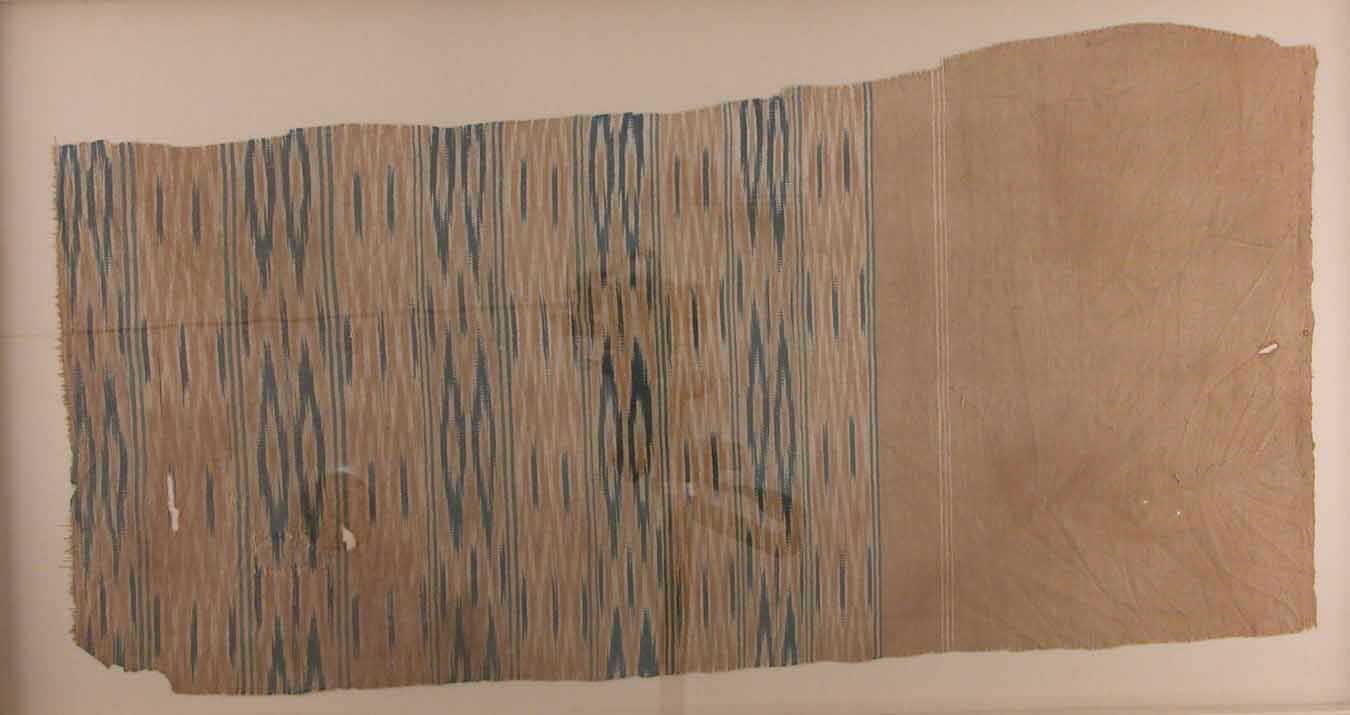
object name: textile fragment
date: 901-1000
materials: cotton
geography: yemen